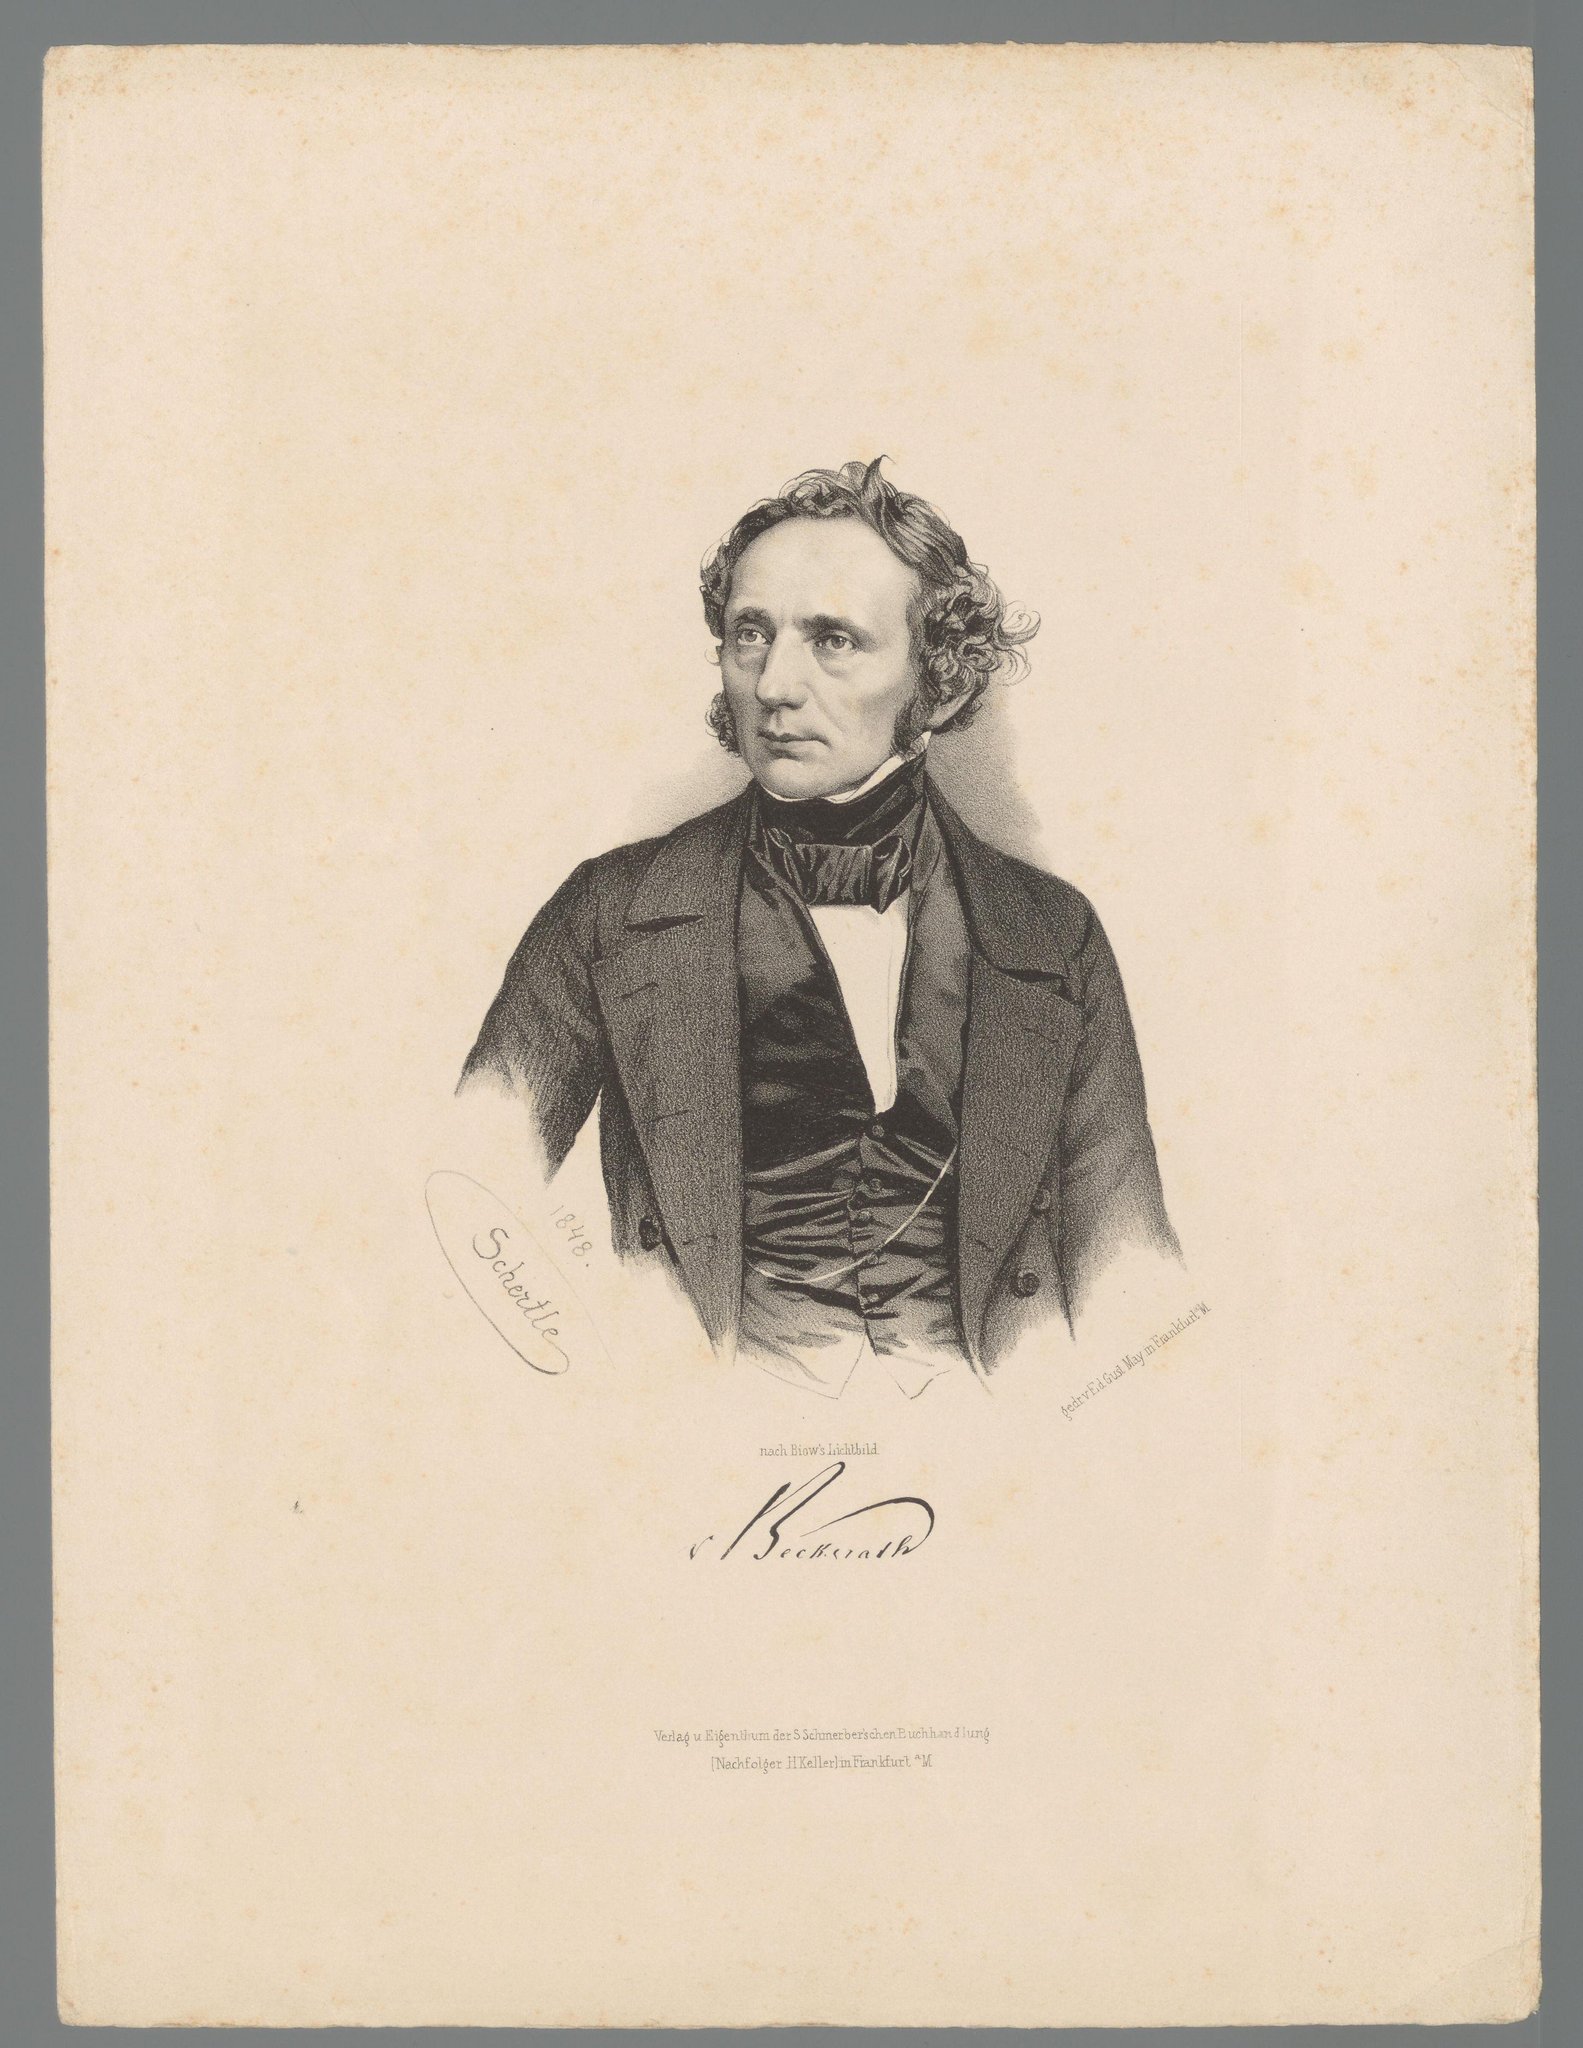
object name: print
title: Portret van Hermann von Beckerath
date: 1848-1849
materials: paper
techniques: lithograph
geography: frankfurt am main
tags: adult man, historical persons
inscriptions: collector's mark: Lugt 2228